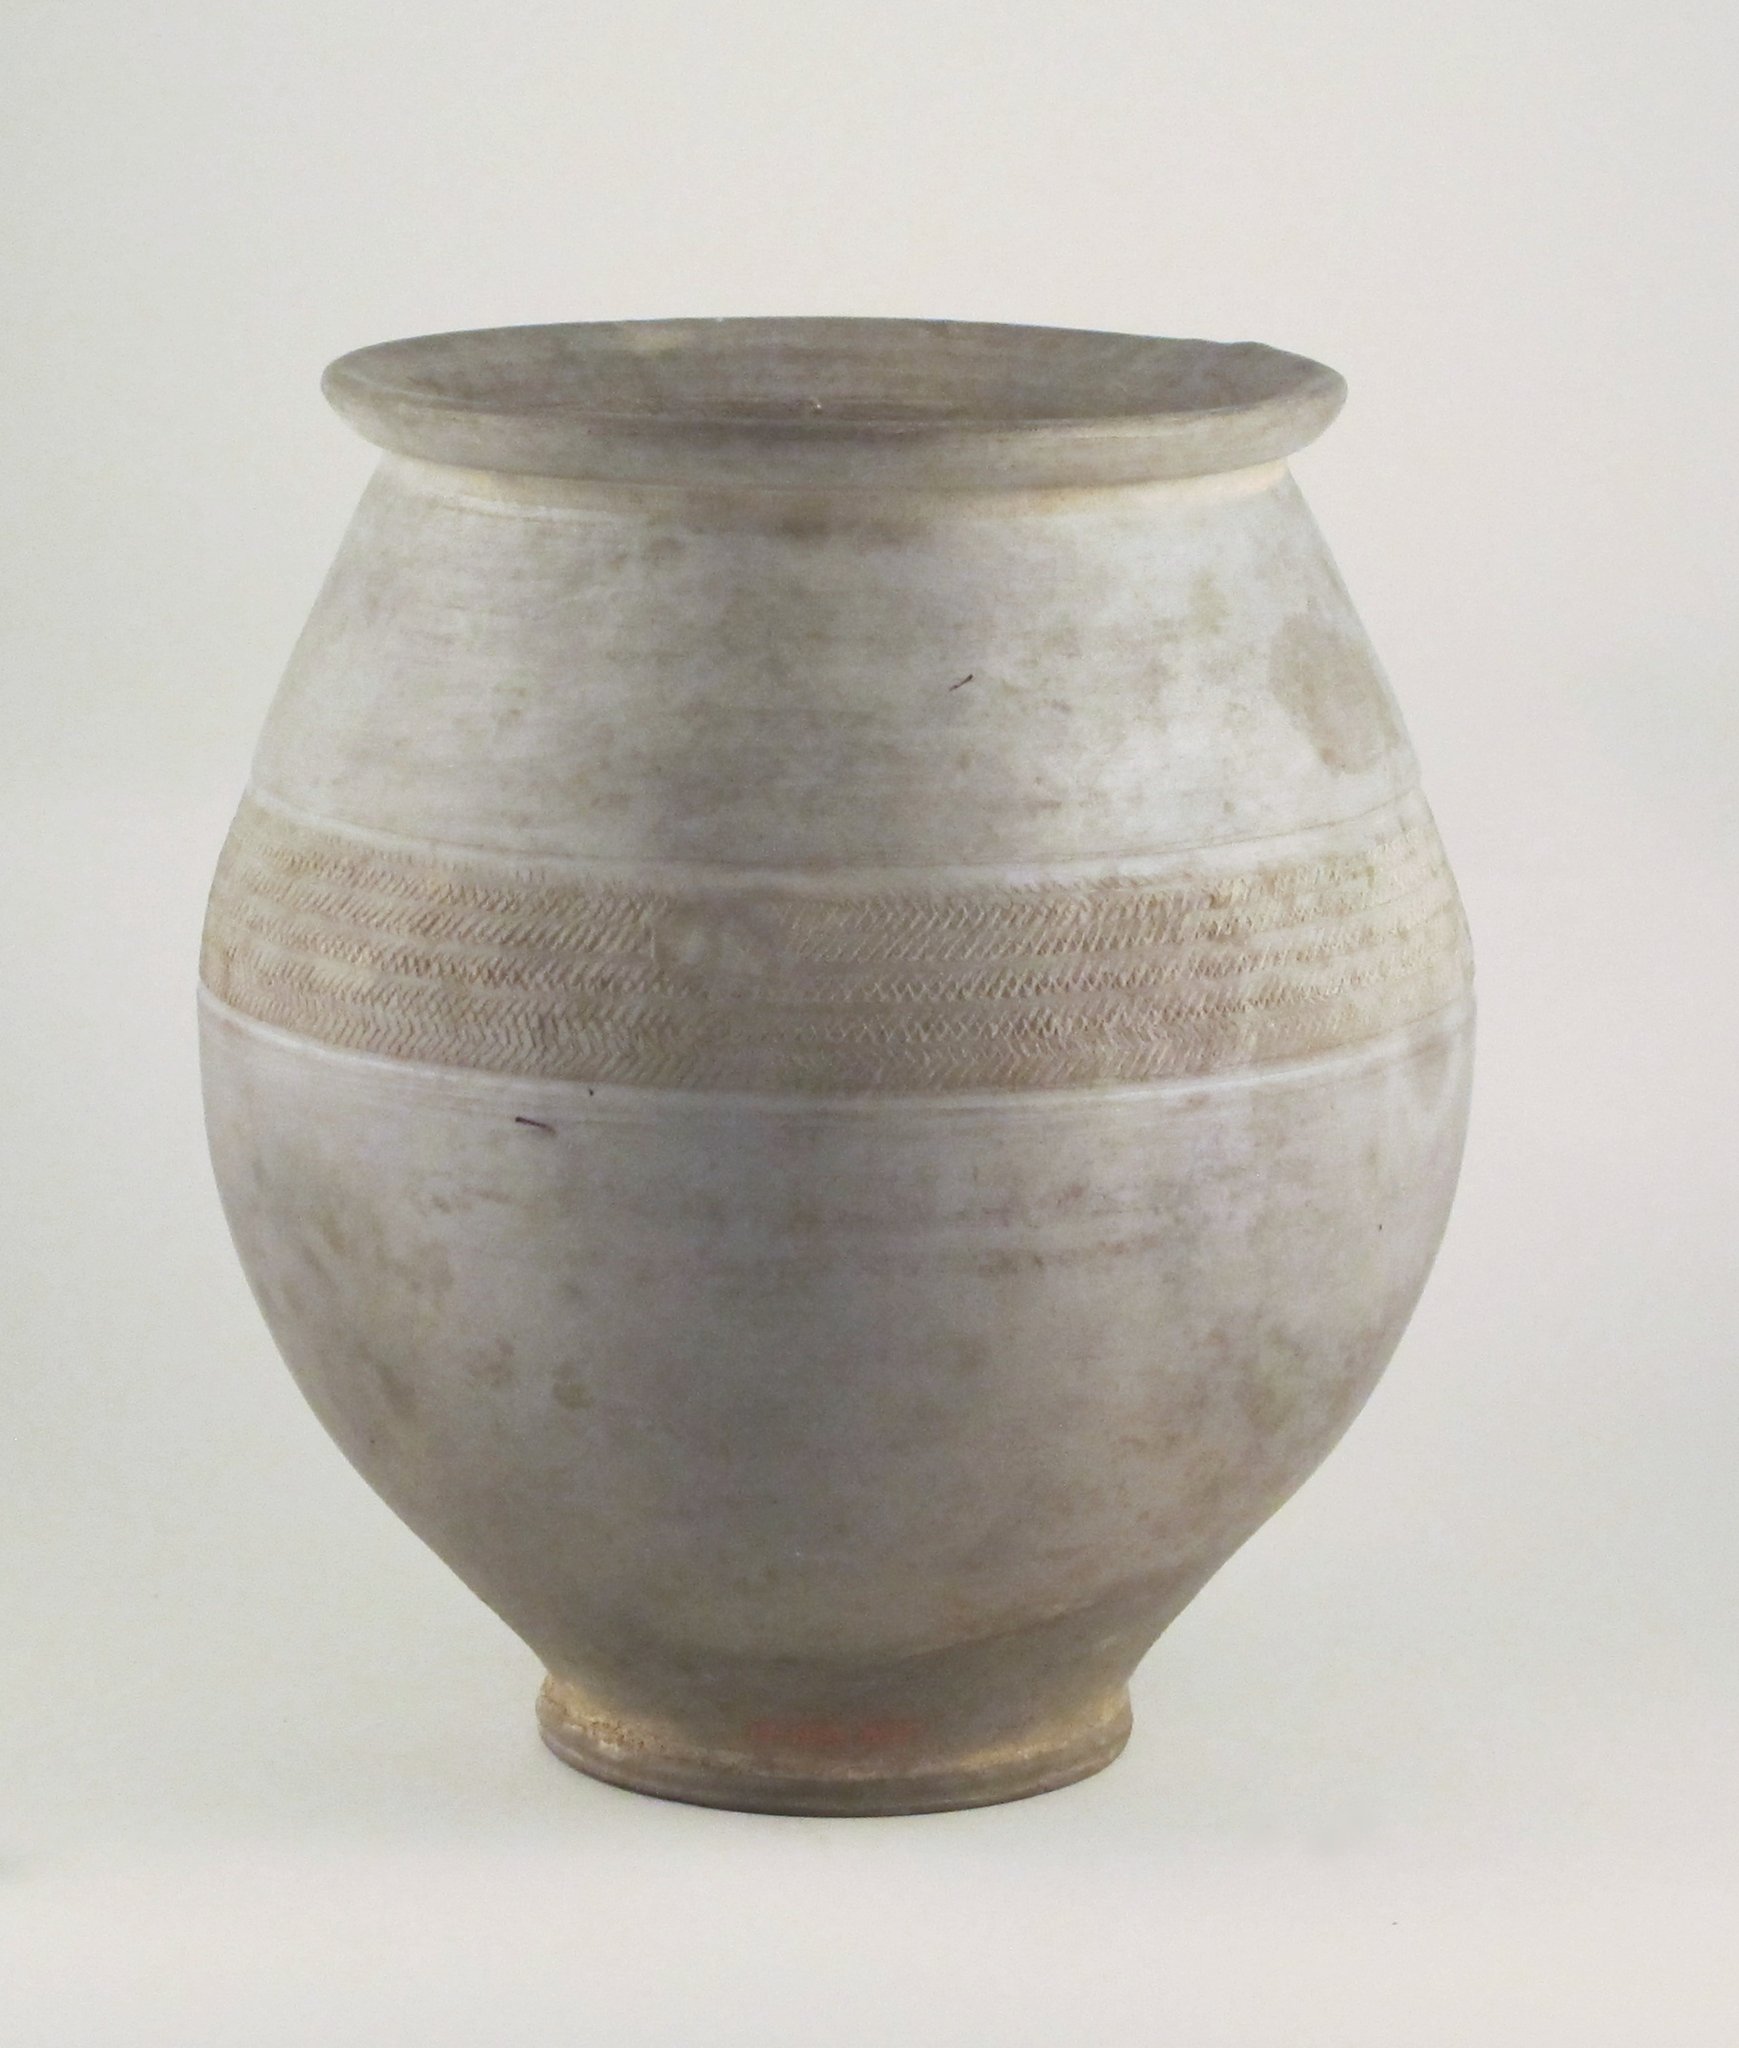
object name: jar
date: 7000 BCE-330 CE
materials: terracotta